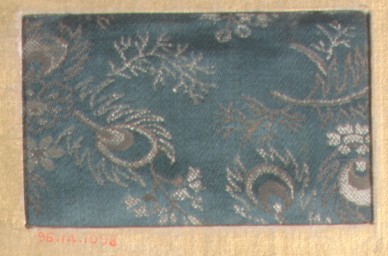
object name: piece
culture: japanese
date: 1701-1900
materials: silk